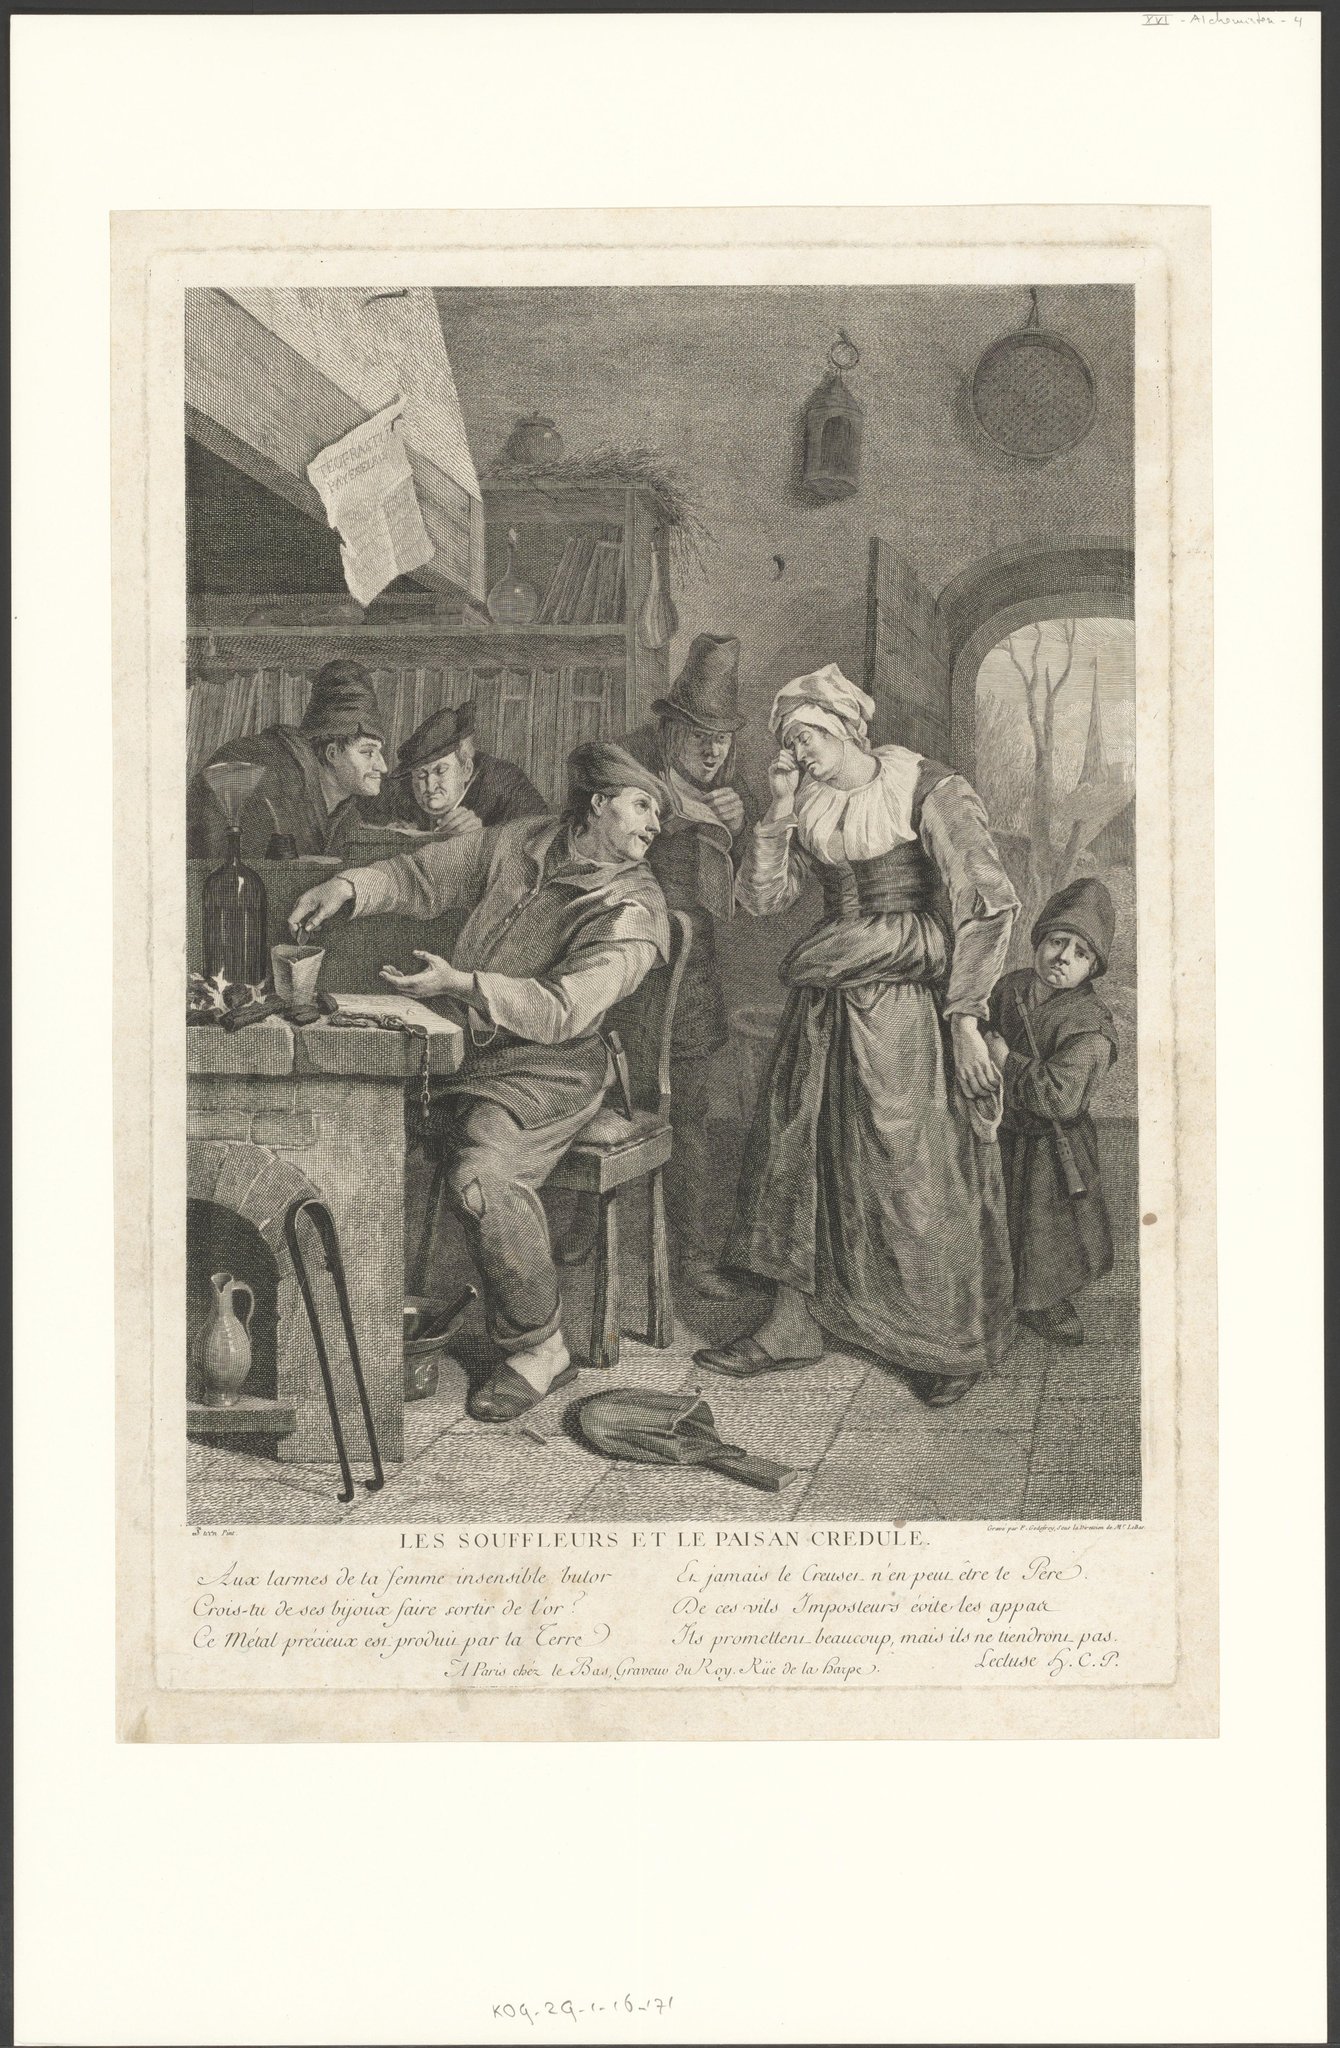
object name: print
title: Les Souffleurs et le paisan credule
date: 1753-1819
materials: paper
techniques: engraving, etching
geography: paris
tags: alchemist at work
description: Drie alchemisten lezen boeken. Voor hen smelt een boer de juwelen van zijn vrouw en probeert alchemie uit. Zijn vrouw staat achter hem te huilen. Aan haar arm een verdrietig kind. Onderaan een zesregelig vers in twee kolommen. Onderwerpsrubrieken binnen de Atlas Zeden en Gewoonten: Onderwijs en Wetenschappen, Alchemisten.